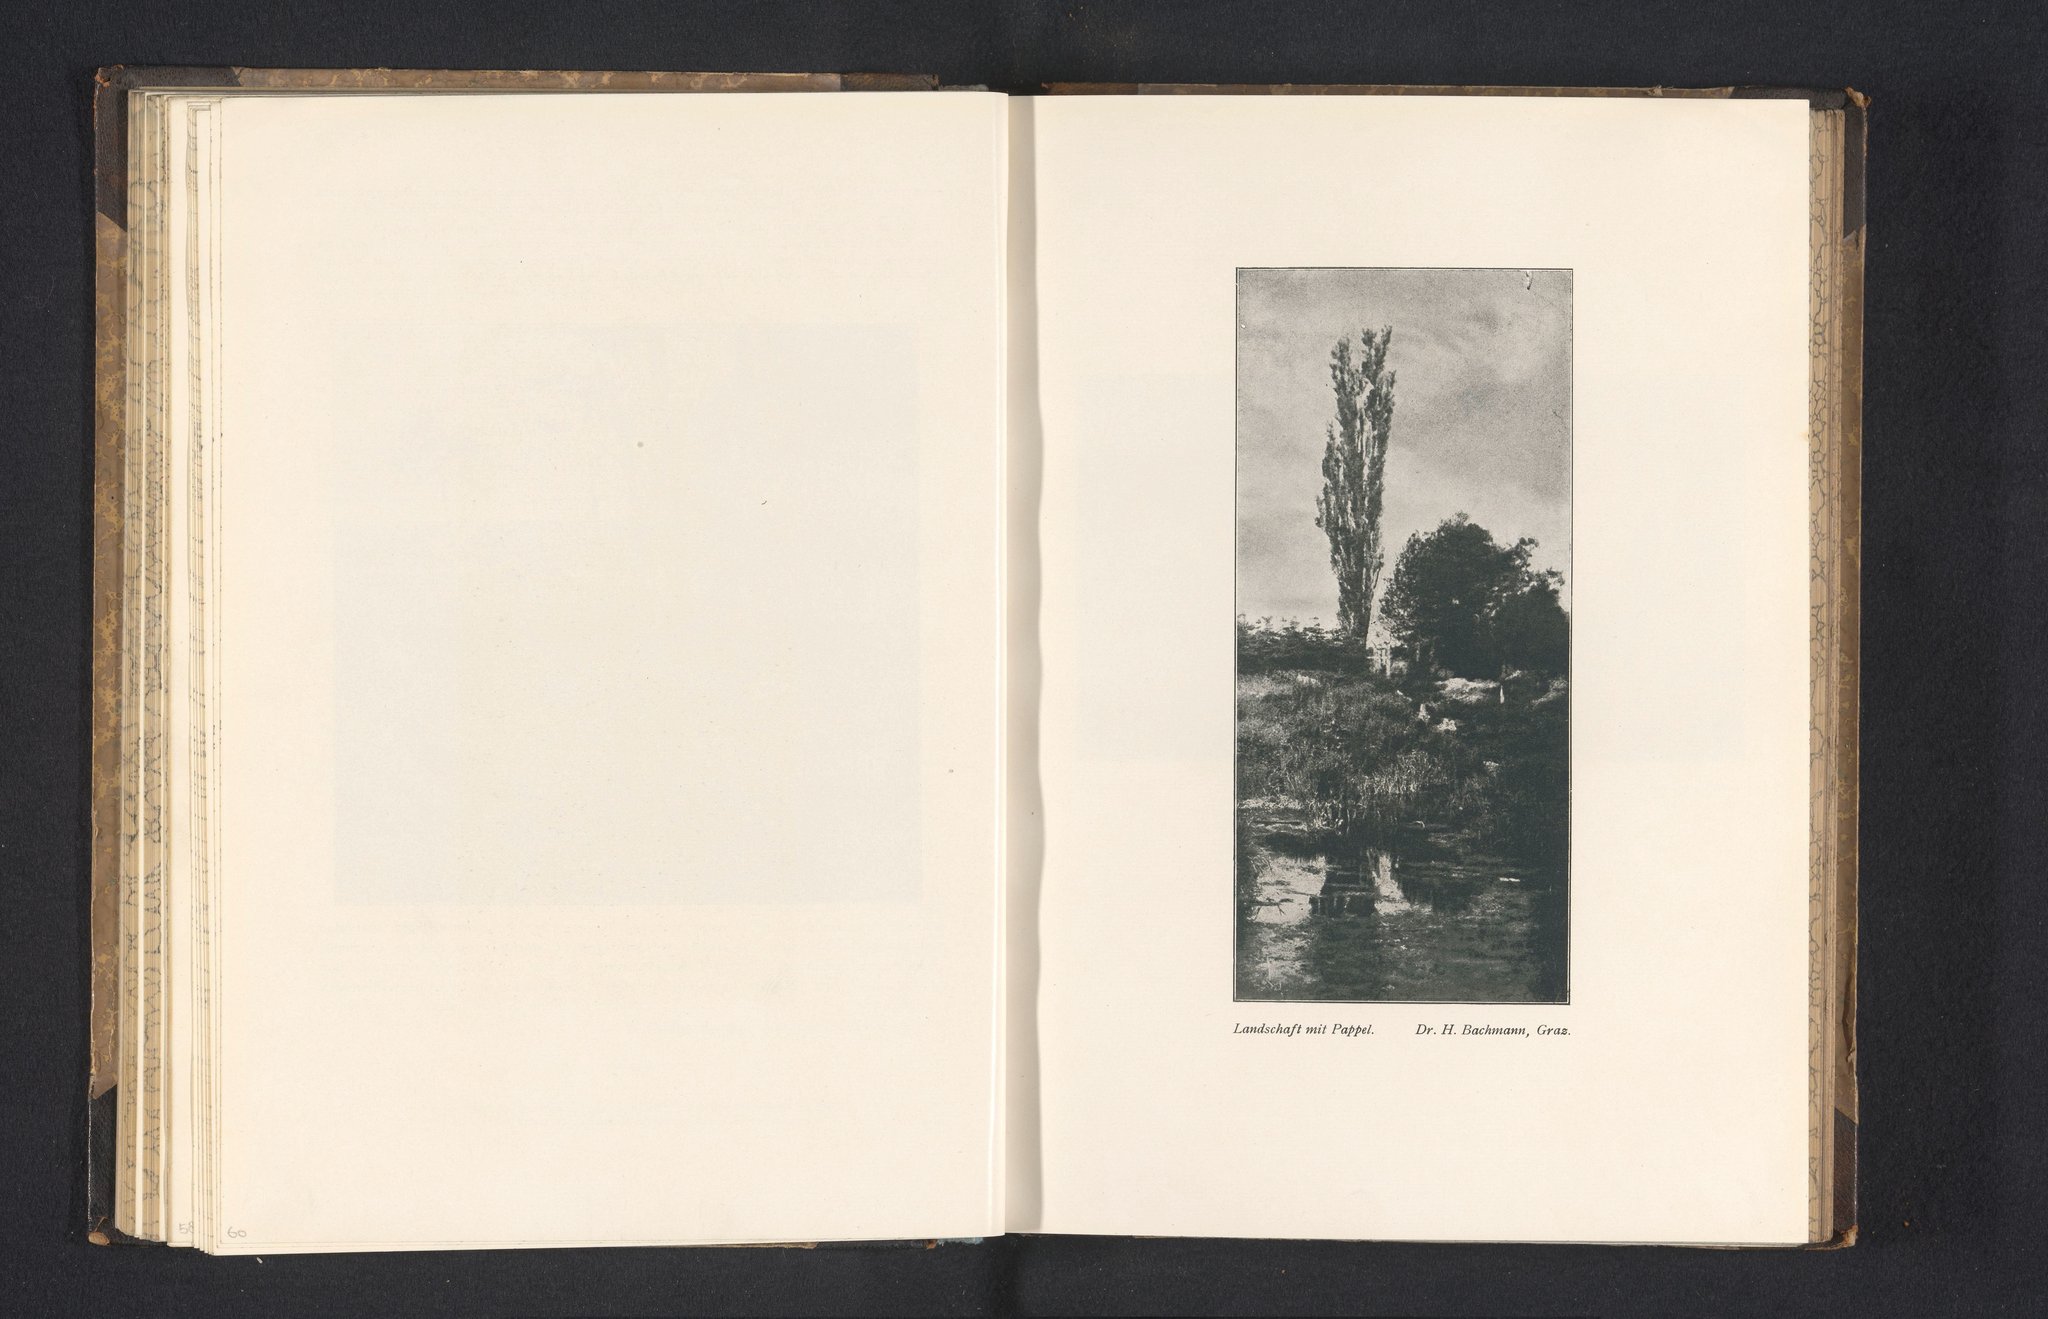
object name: photomechanical print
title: Landschaft mit Pappel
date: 1898-1903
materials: paper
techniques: autotype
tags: landscapes, trees: poplar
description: Prent op tweede ongenummerde pagina na pagina 108.